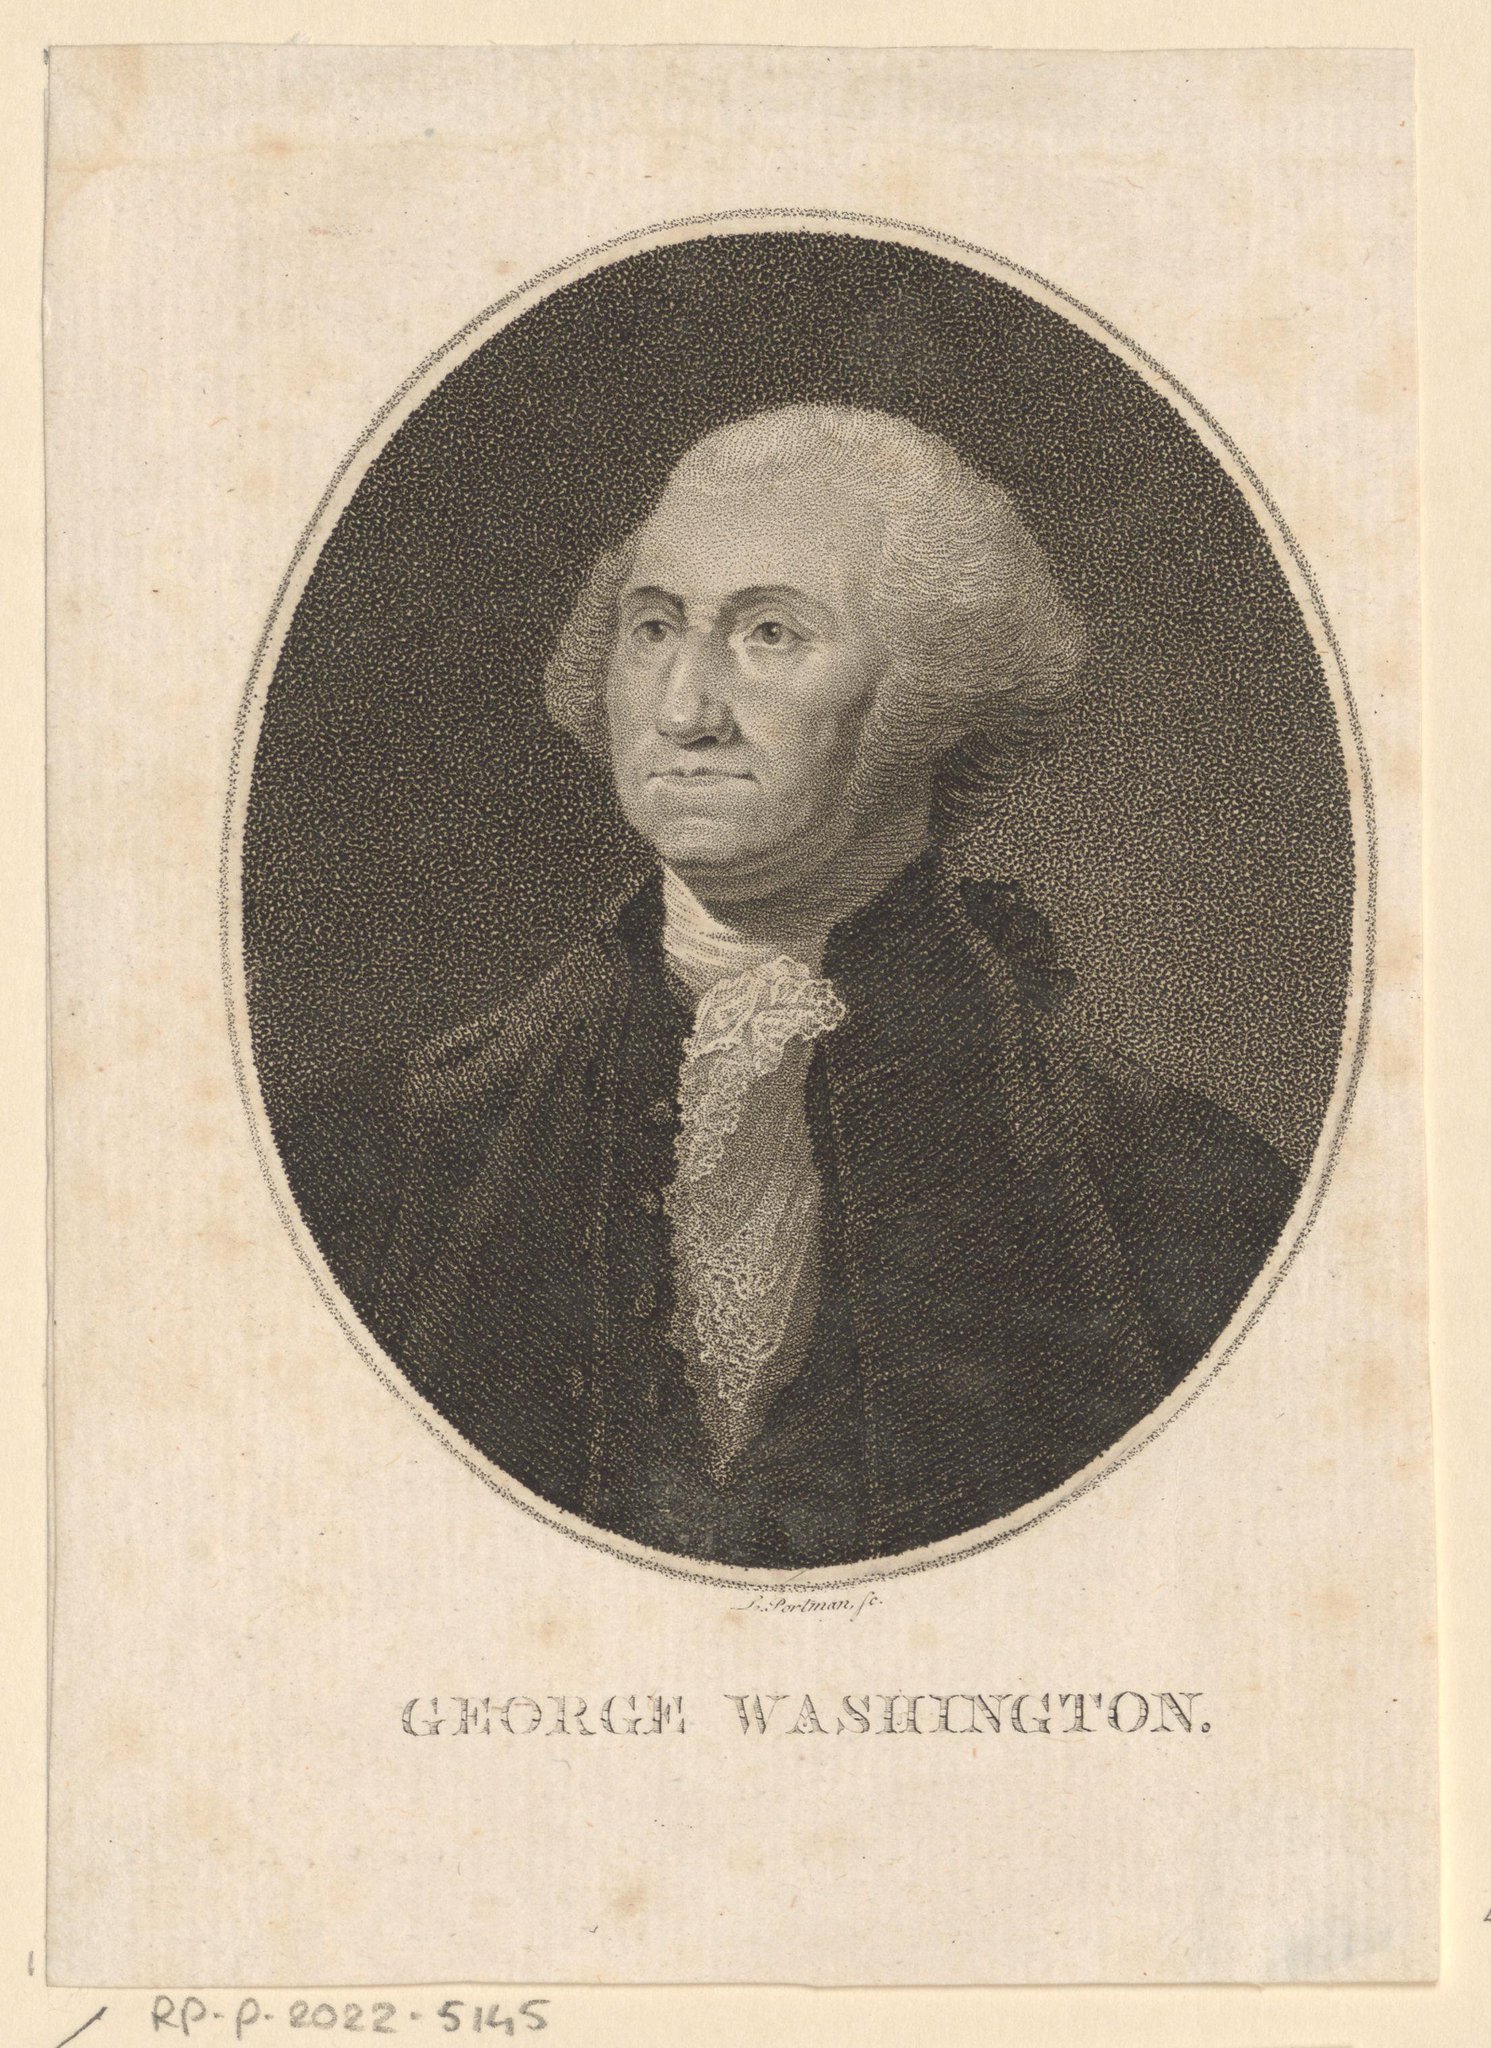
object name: print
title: Portret van George Washington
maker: ludwig gottlieb portman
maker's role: print maker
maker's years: 1772-1828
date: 1805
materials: paper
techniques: etching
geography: amsterdam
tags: president ~ head of republic, historical persons